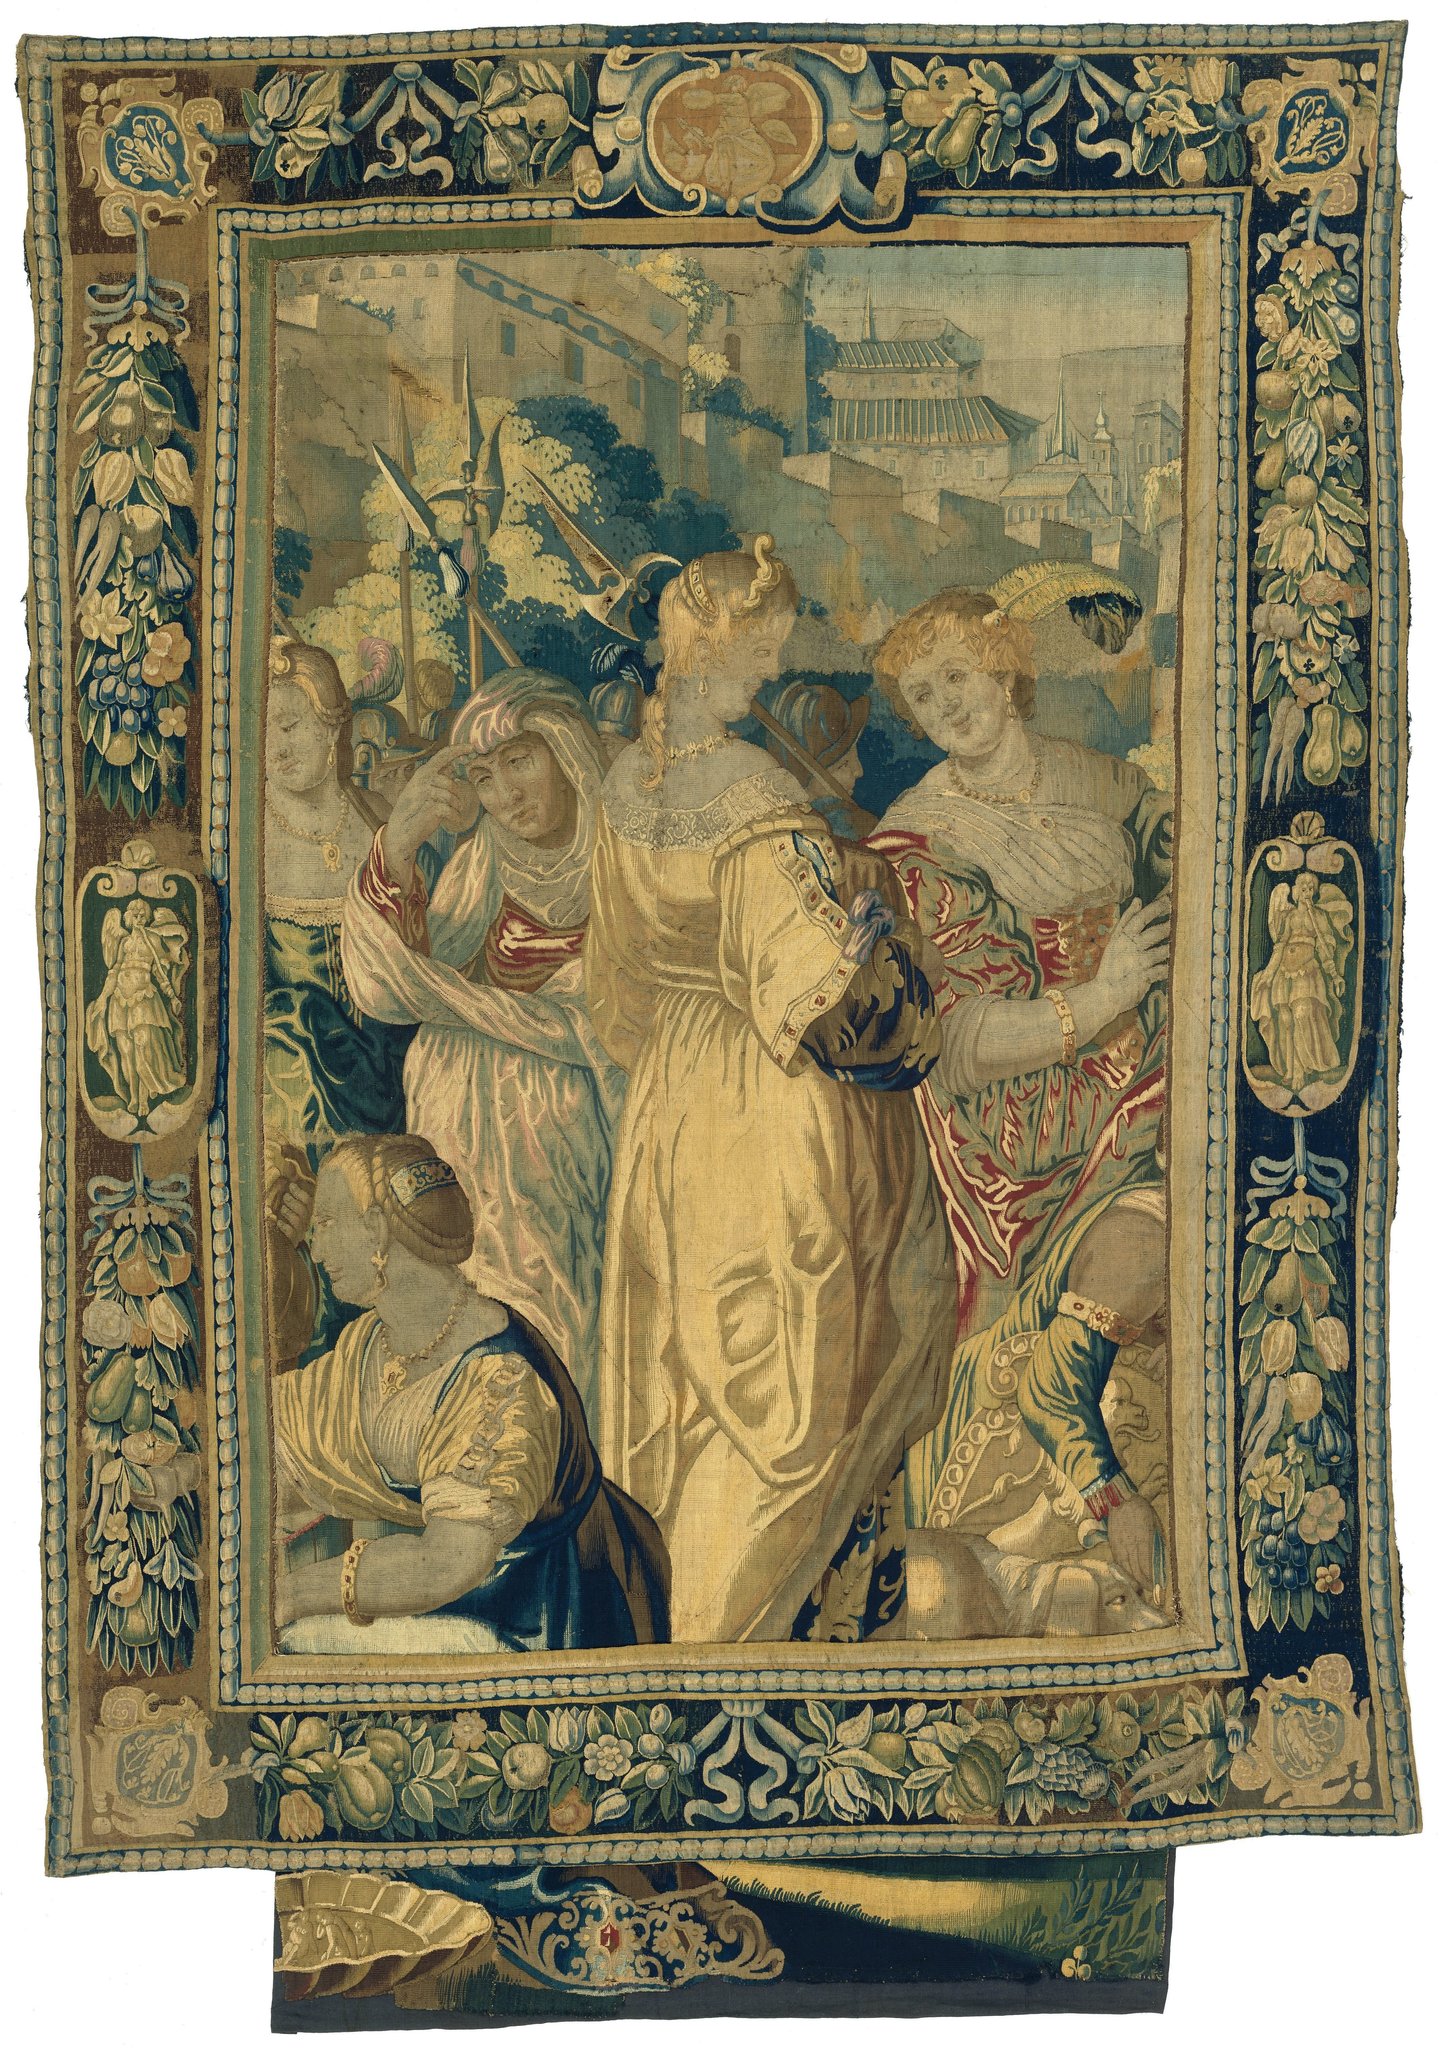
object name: tapestry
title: Onbekende scène met vijf vrouwenfiguren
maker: Anonymous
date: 1640-1650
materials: silk, wool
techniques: tapestry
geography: southern netherlands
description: Wandtapijt waarvan de voorstelling nog niet geidentificeerd is. Op de voorgrond vijf vrouwenfiguren op de rug gezien. Op de achtergrond een begroeide vestingmuur met kantelen, torens en daken.